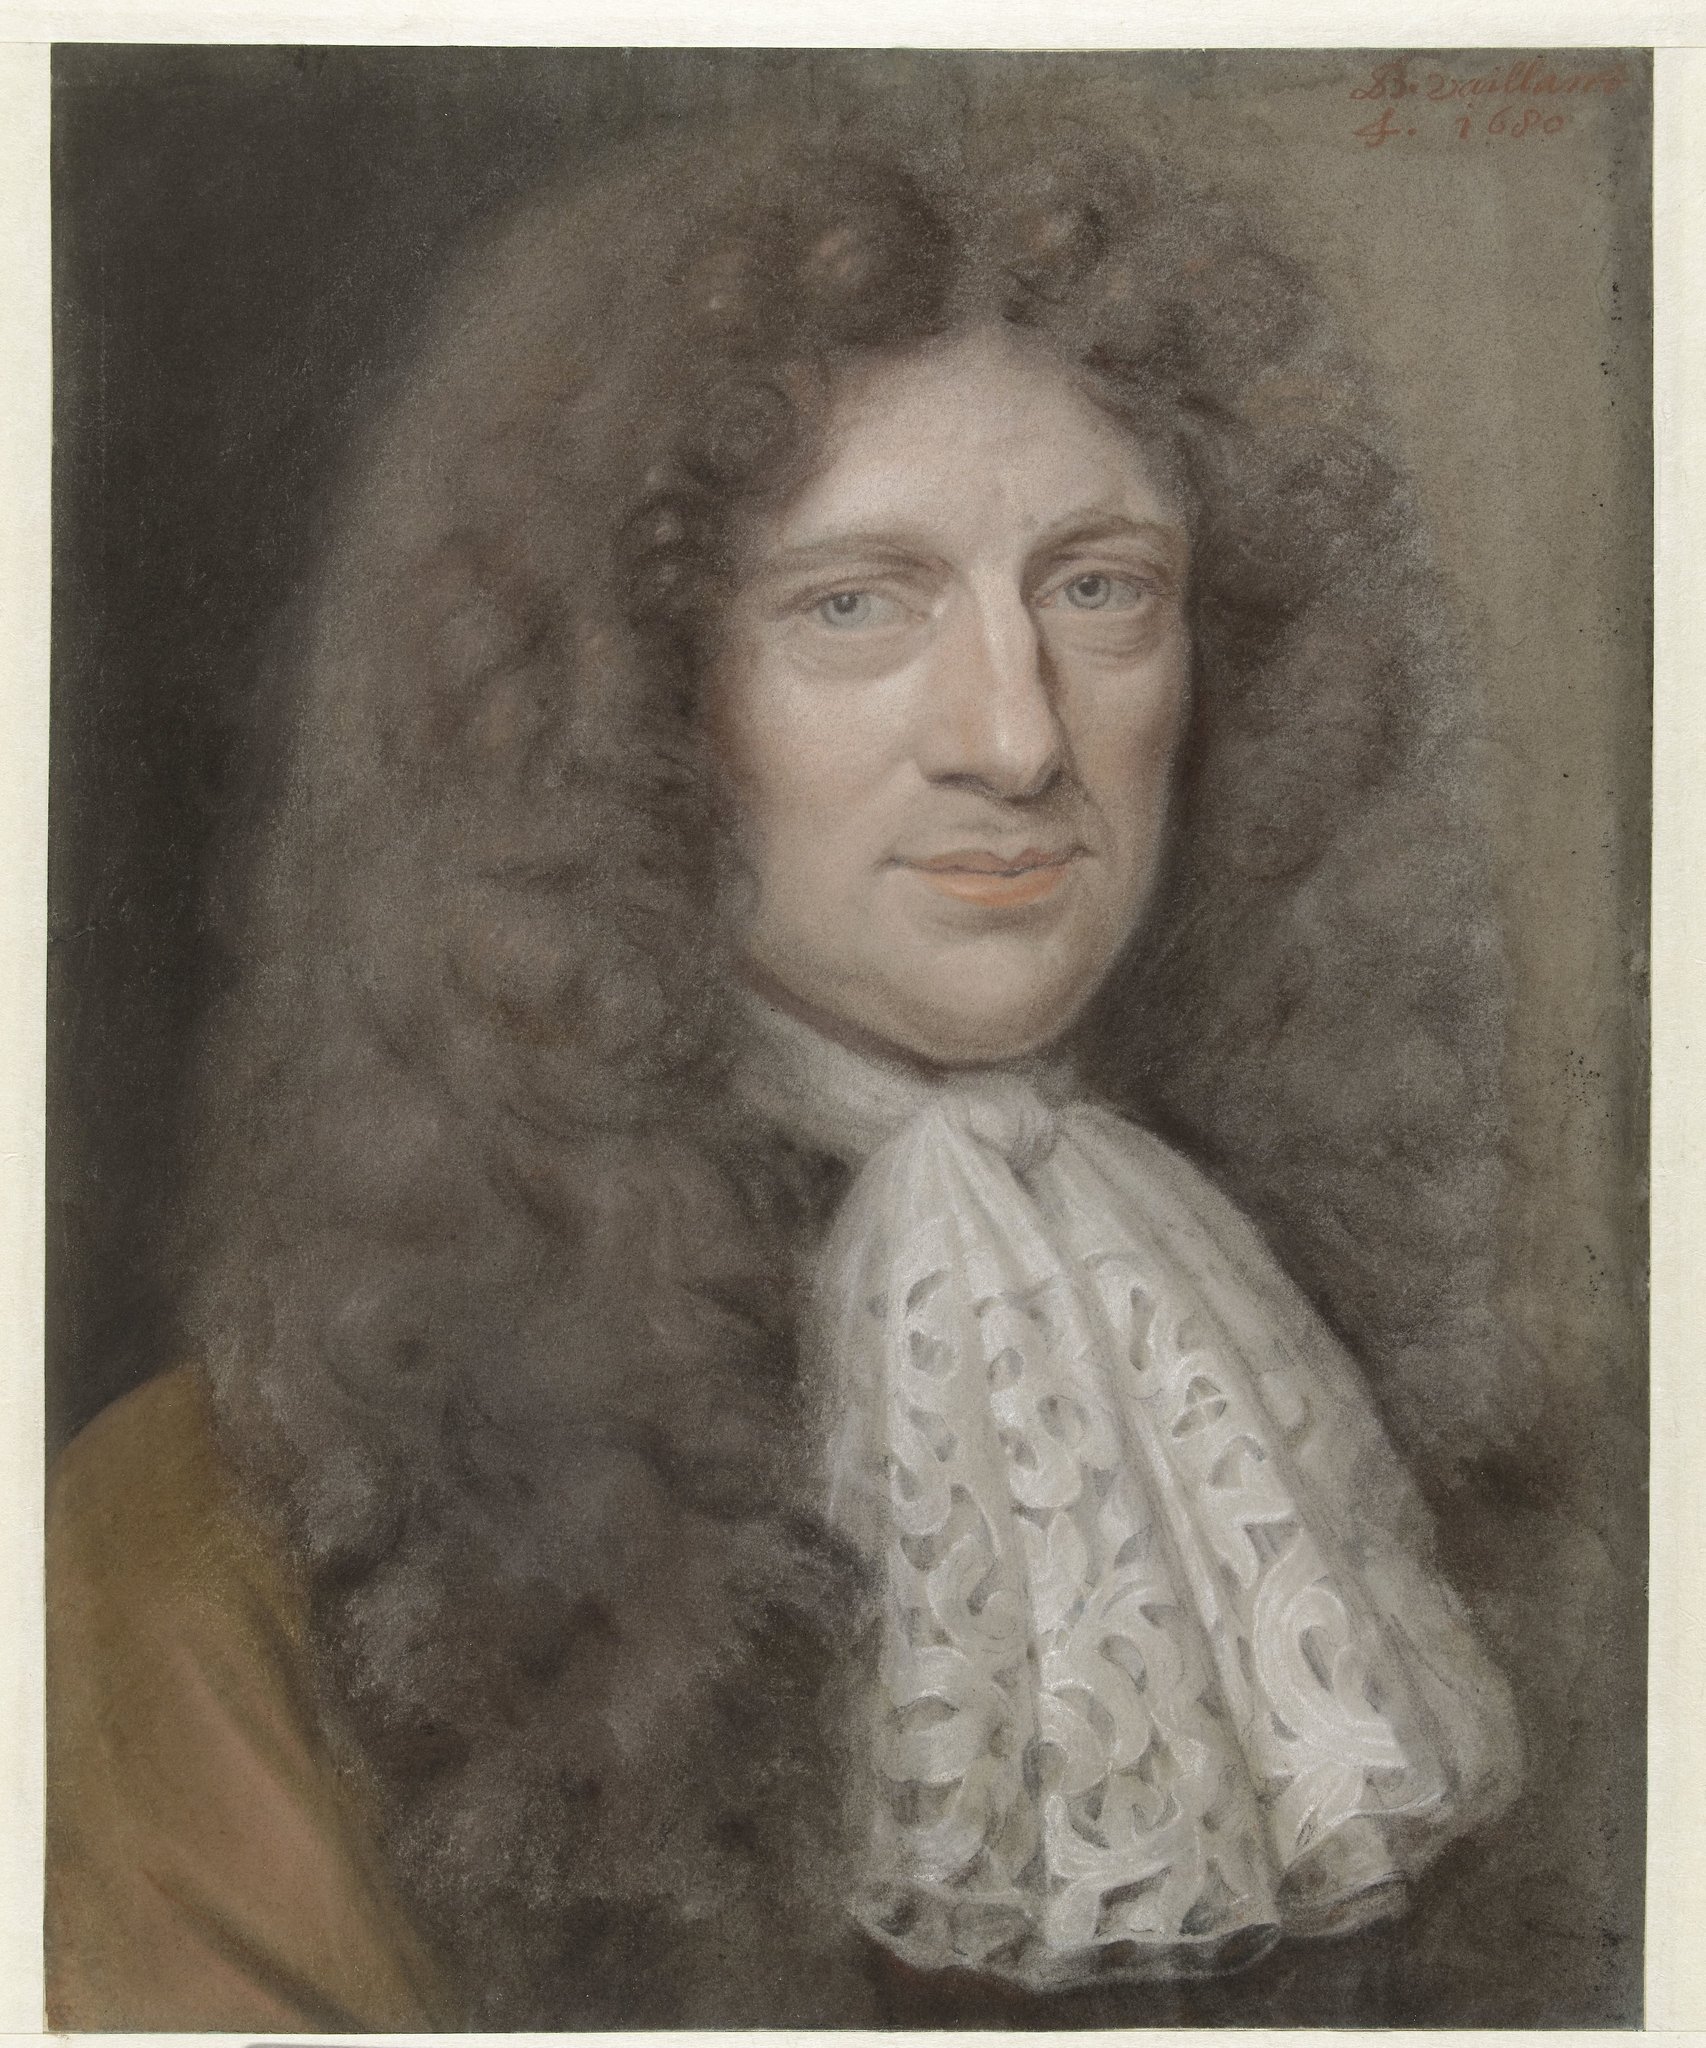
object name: drawing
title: Portret van een onbekende man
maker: bernard vaillant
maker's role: draughtsman, painter, print maker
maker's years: 1632-1698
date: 1680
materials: paper, pastel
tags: anonymous historical person portrayed alone